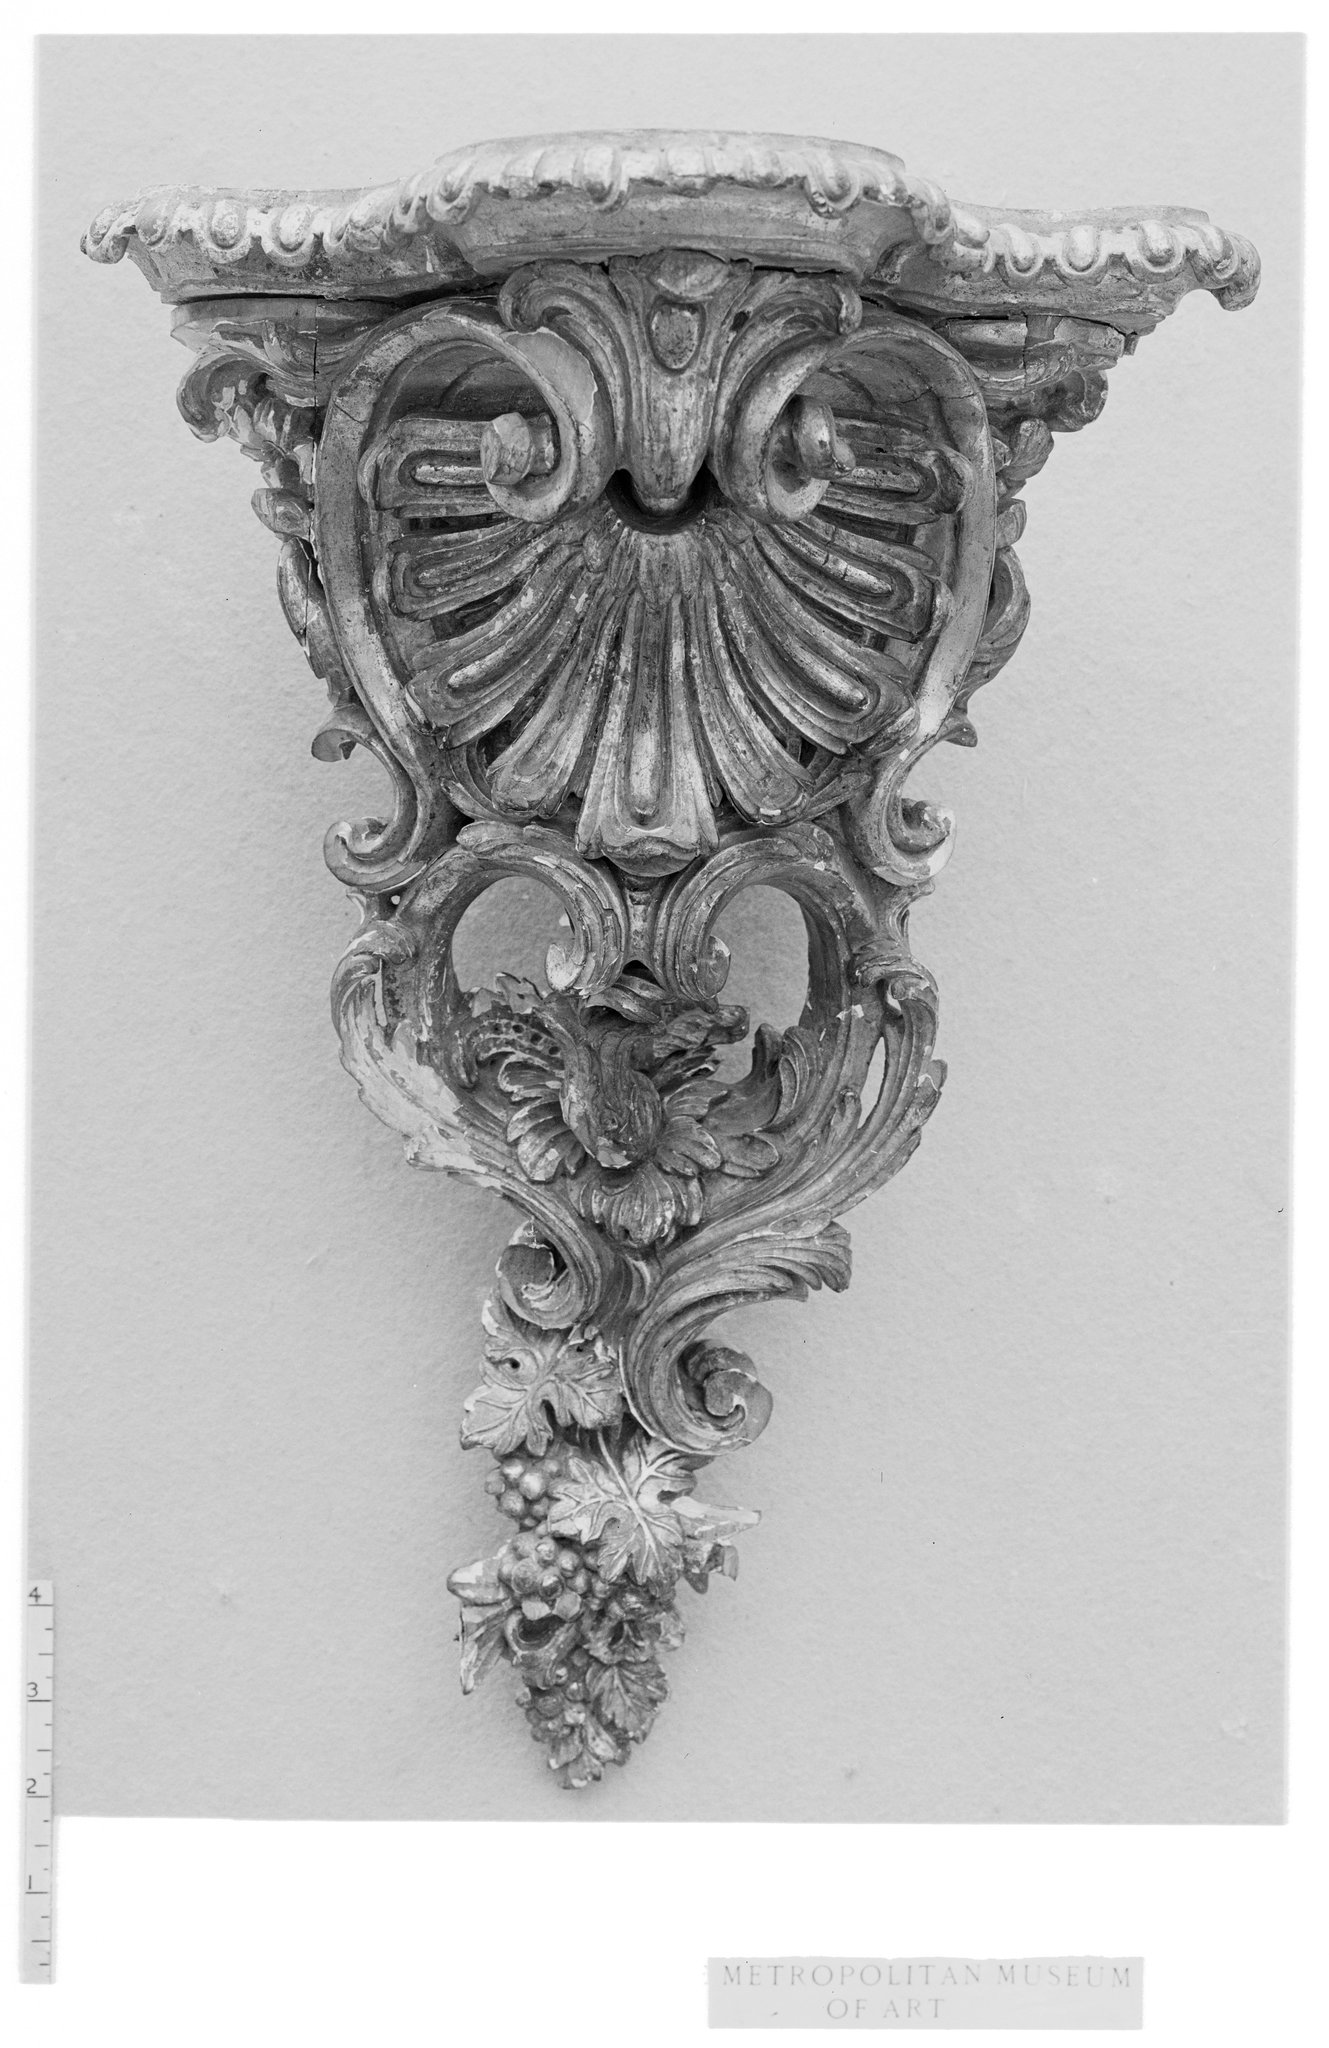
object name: console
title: Console (console d'applique)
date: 1701-1725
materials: wood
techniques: carving, gilding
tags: flowers